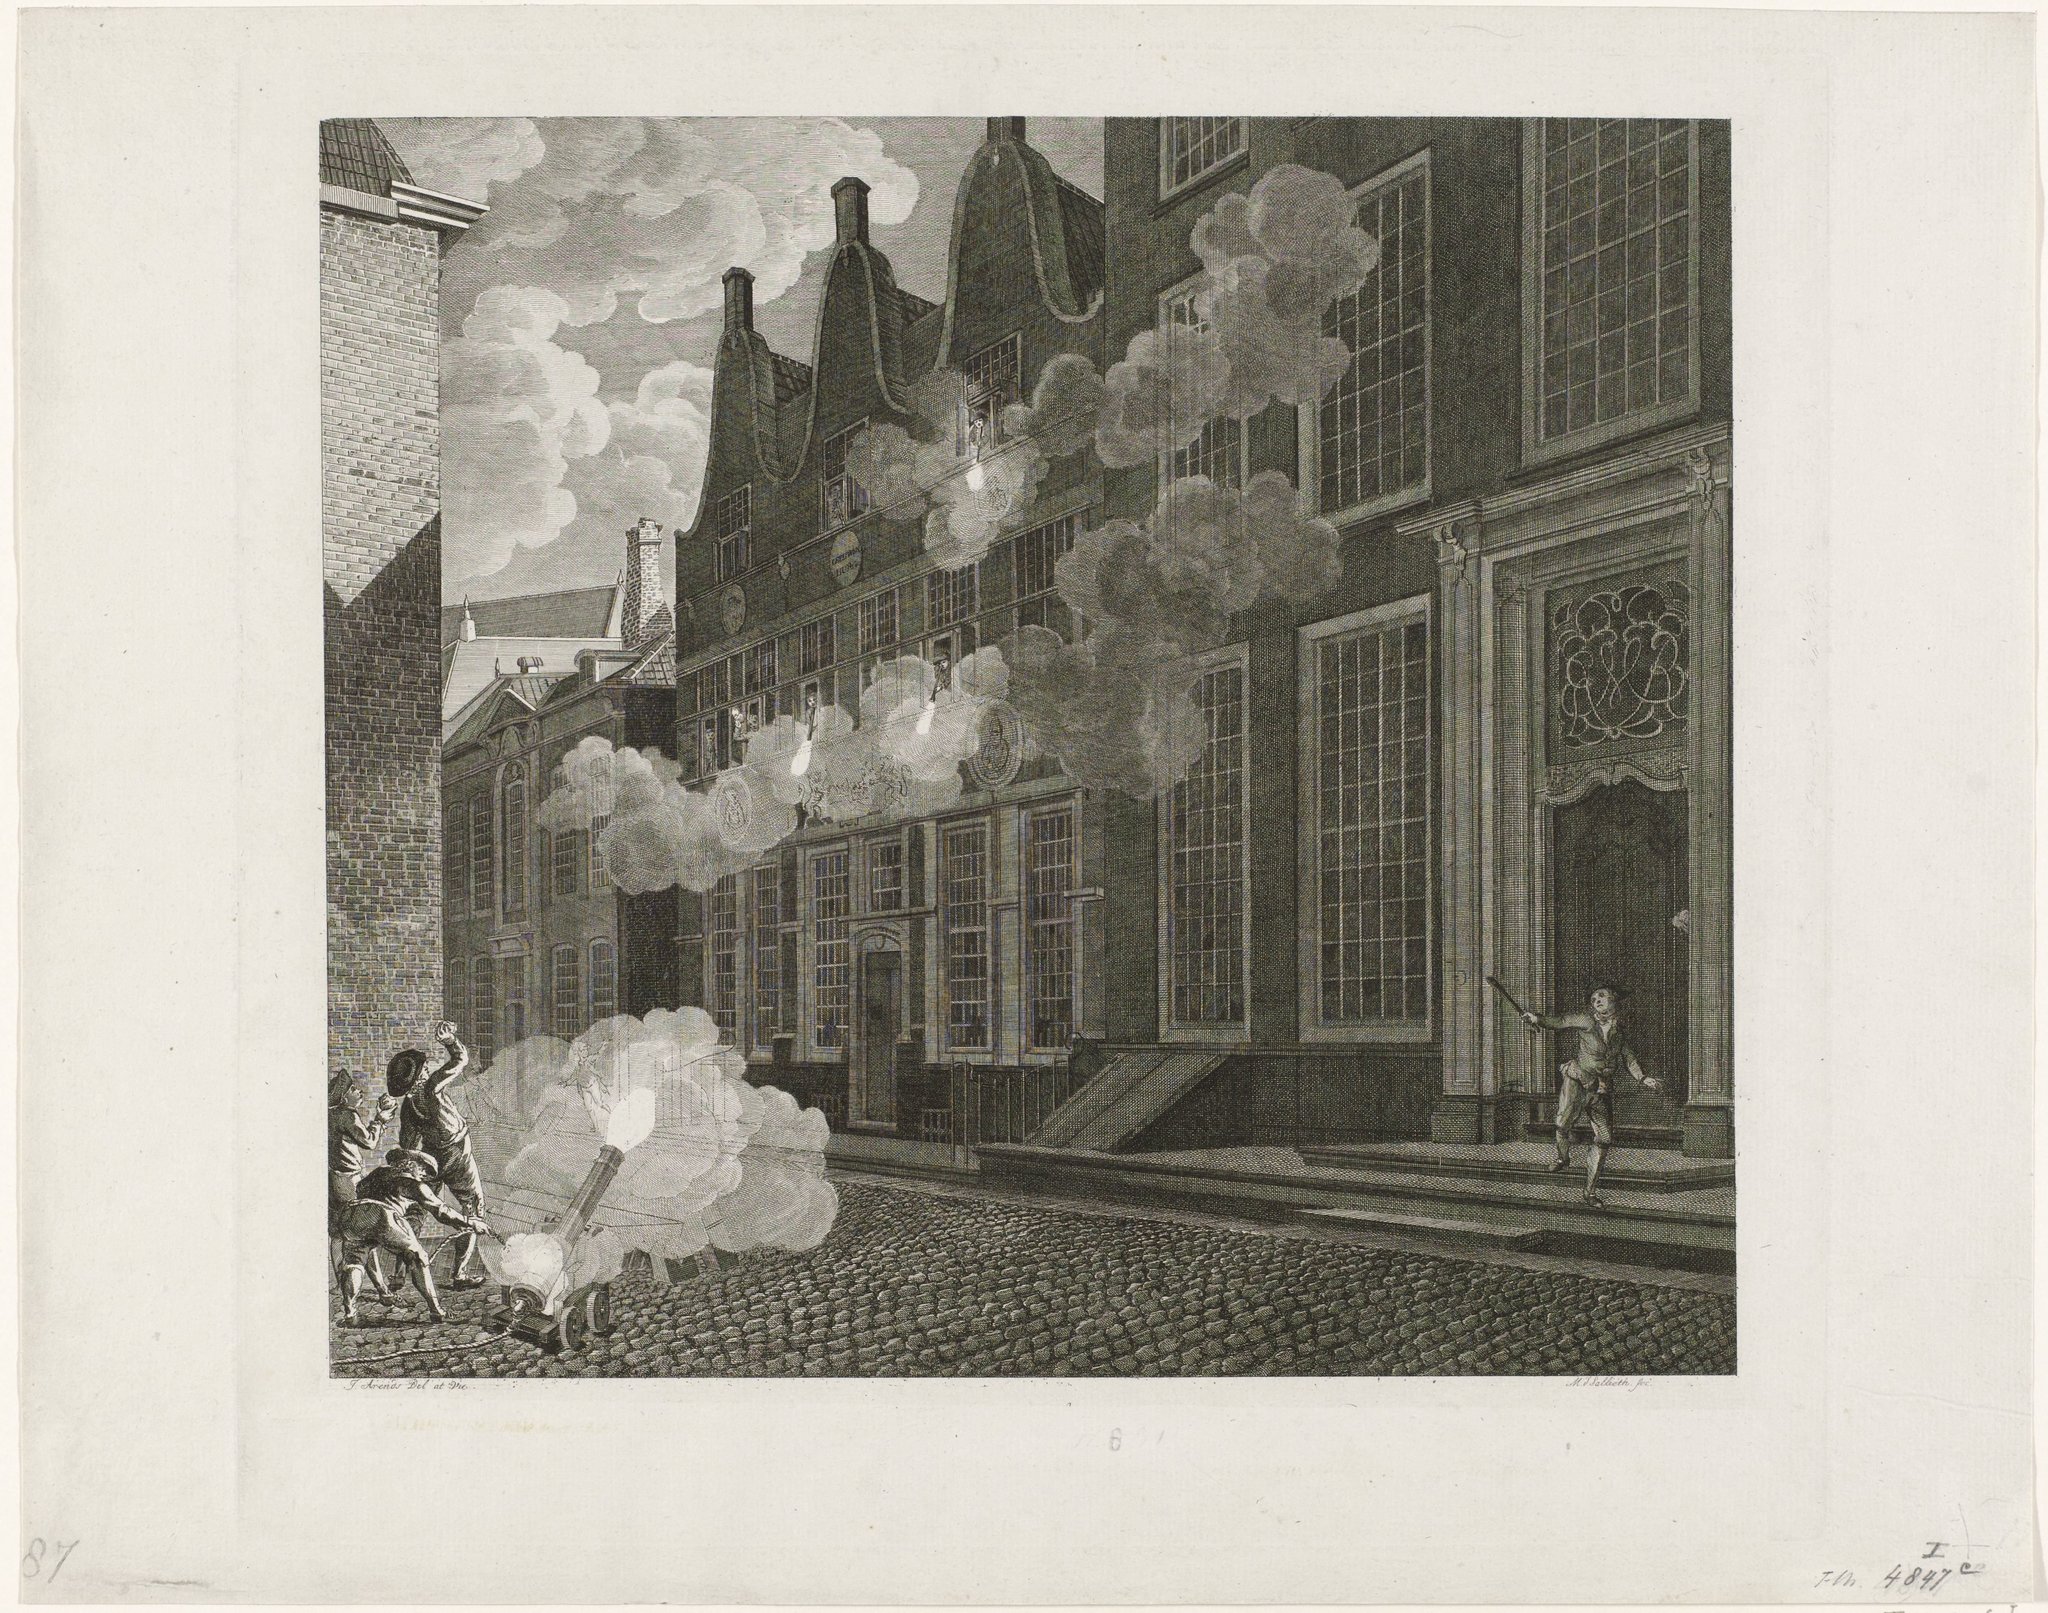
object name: print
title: Beschieting van het huis van Lucas van Steveninck, 1787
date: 1787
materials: paper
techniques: engraving, etching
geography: middelburg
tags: amsterdam, street-fights, riots, patriots (1780-1795)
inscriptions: collector's mark: Lugt 2228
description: Oranjegezinden beschieten met een klein kanon het Huis Leeuwenburg te Middelburg van de patriotse arts Lucas van Steveninck, in de nacht van 30 juni op 1 juli 1787. De bewoners schieten vanuit de vensters van het huis met geweren terug.